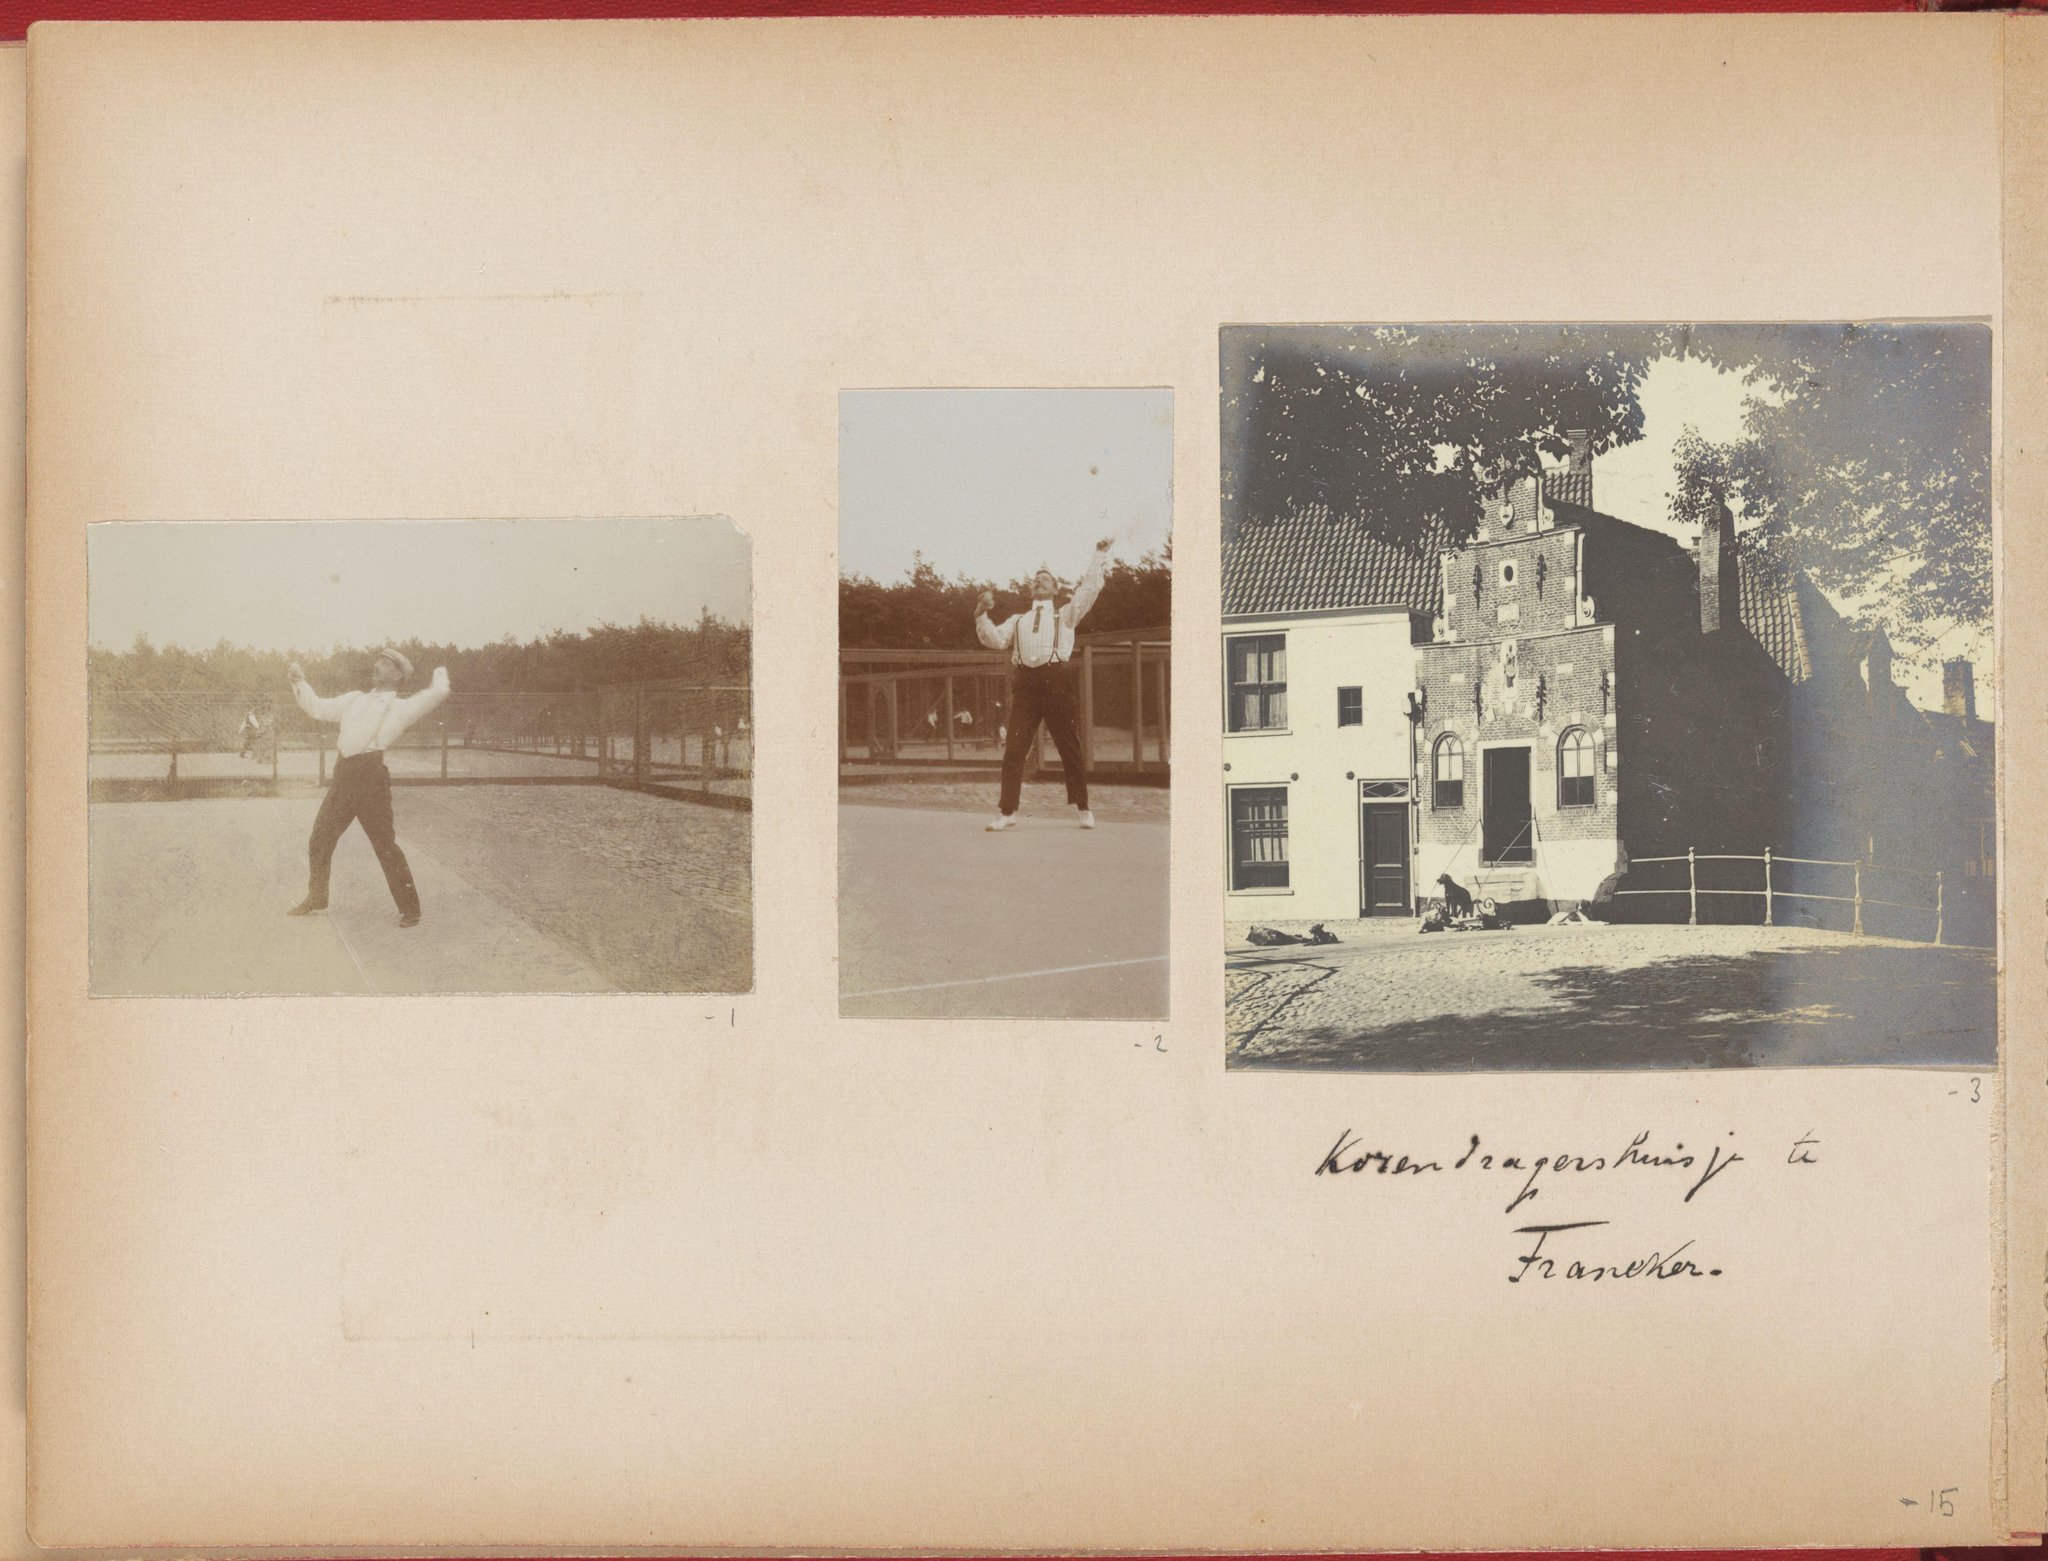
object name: photograph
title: Tenniser slaat op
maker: gerard aalbersberg (us)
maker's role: amateurfotograaf, arts, chirurg, gynaecoloog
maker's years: 1870-1934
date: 1899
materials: cardboard, paper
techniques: collodion silver print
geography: netherlands